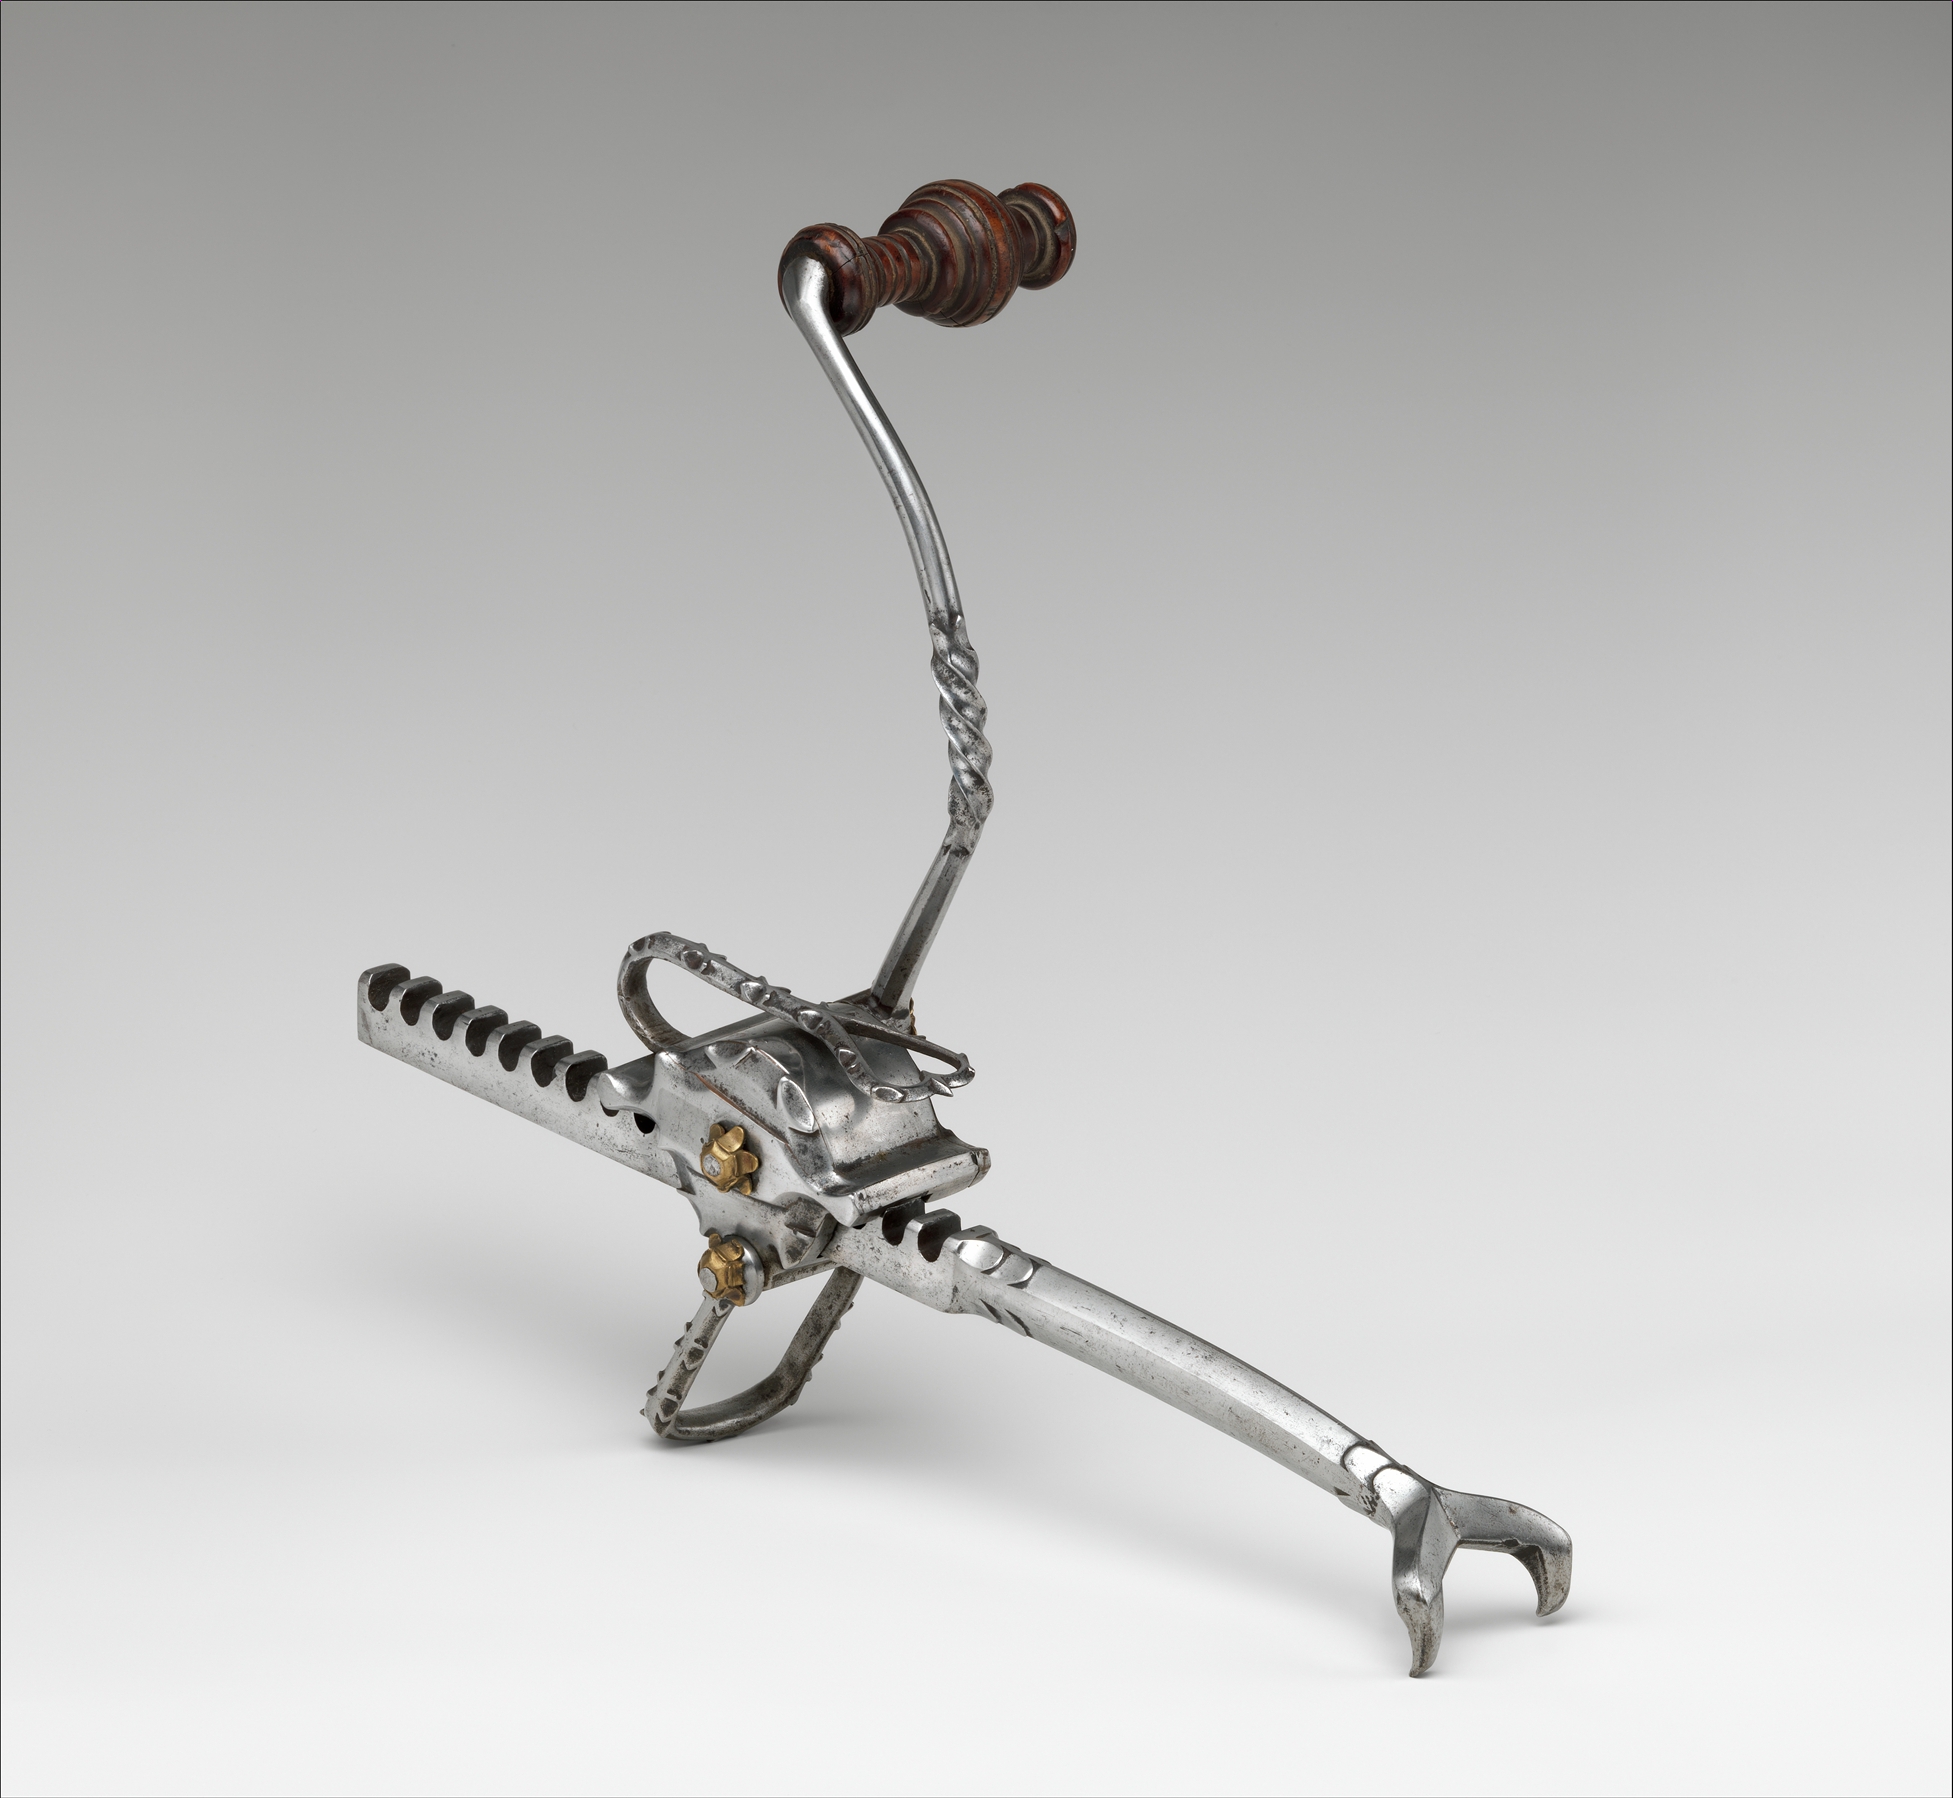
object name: cranequin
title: Cranequin from the Armory of Emperor Maximilan I (reigned 1493/1508–19)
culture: central or western european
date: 1505-1519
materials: copper alloy, steel, wood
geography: austria